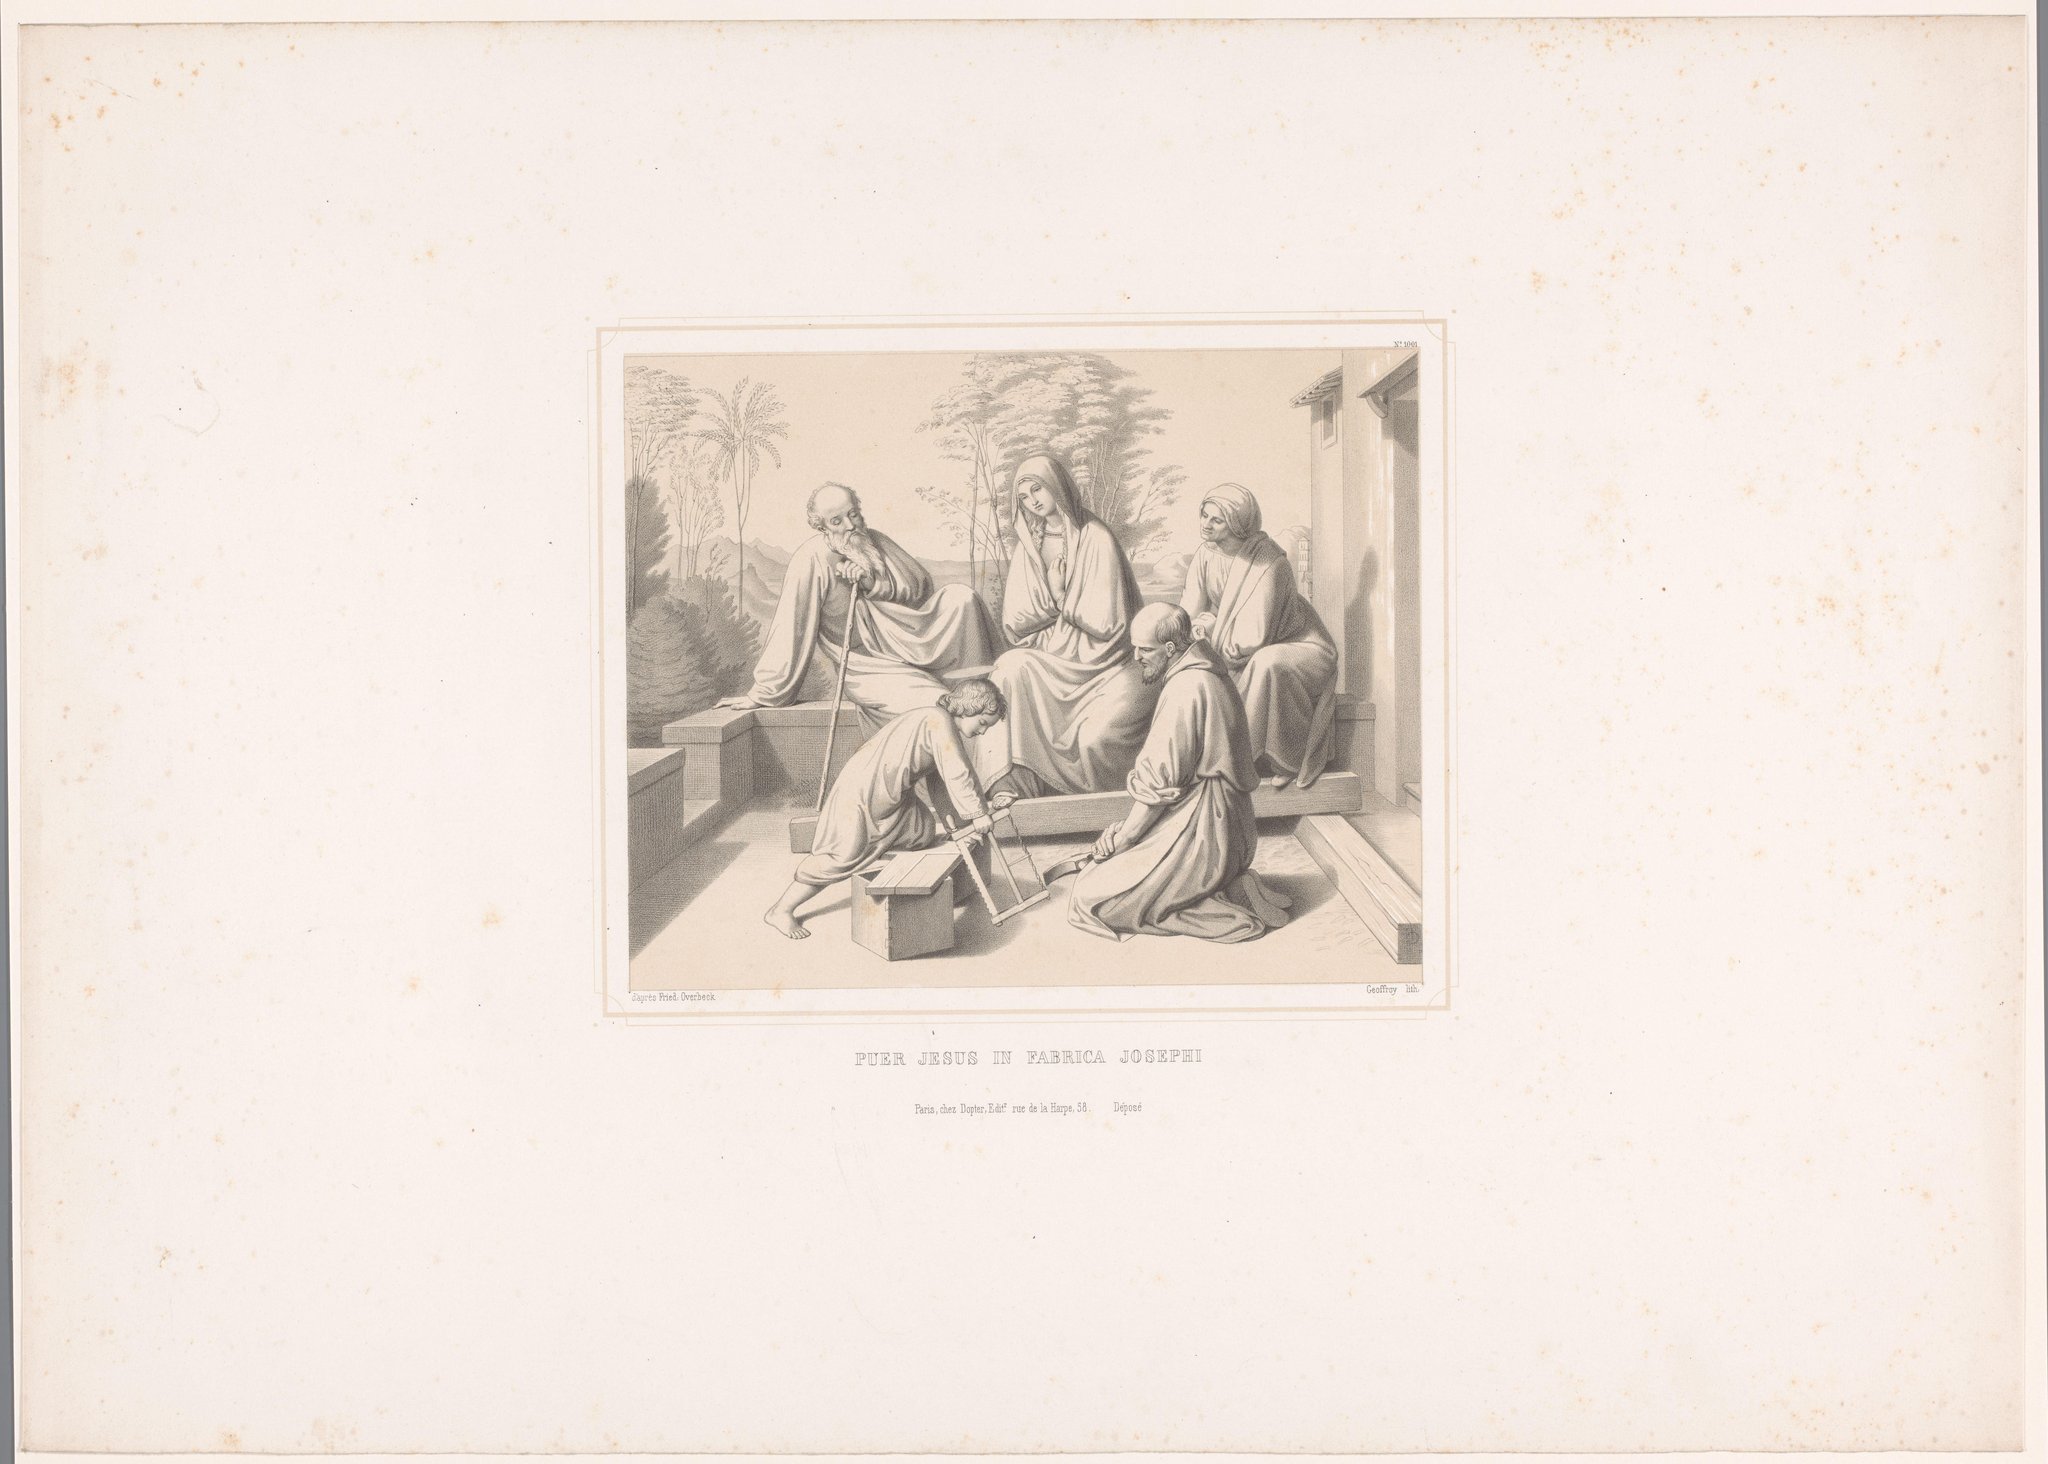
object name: print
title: Puer Jesus in fabrica Josephi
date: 1850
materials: paper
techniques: tone lithography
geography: paris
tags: joseph with the christ-child (and mary) in his carpenter's workshop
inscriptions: collector's mark: Lugt 2228a